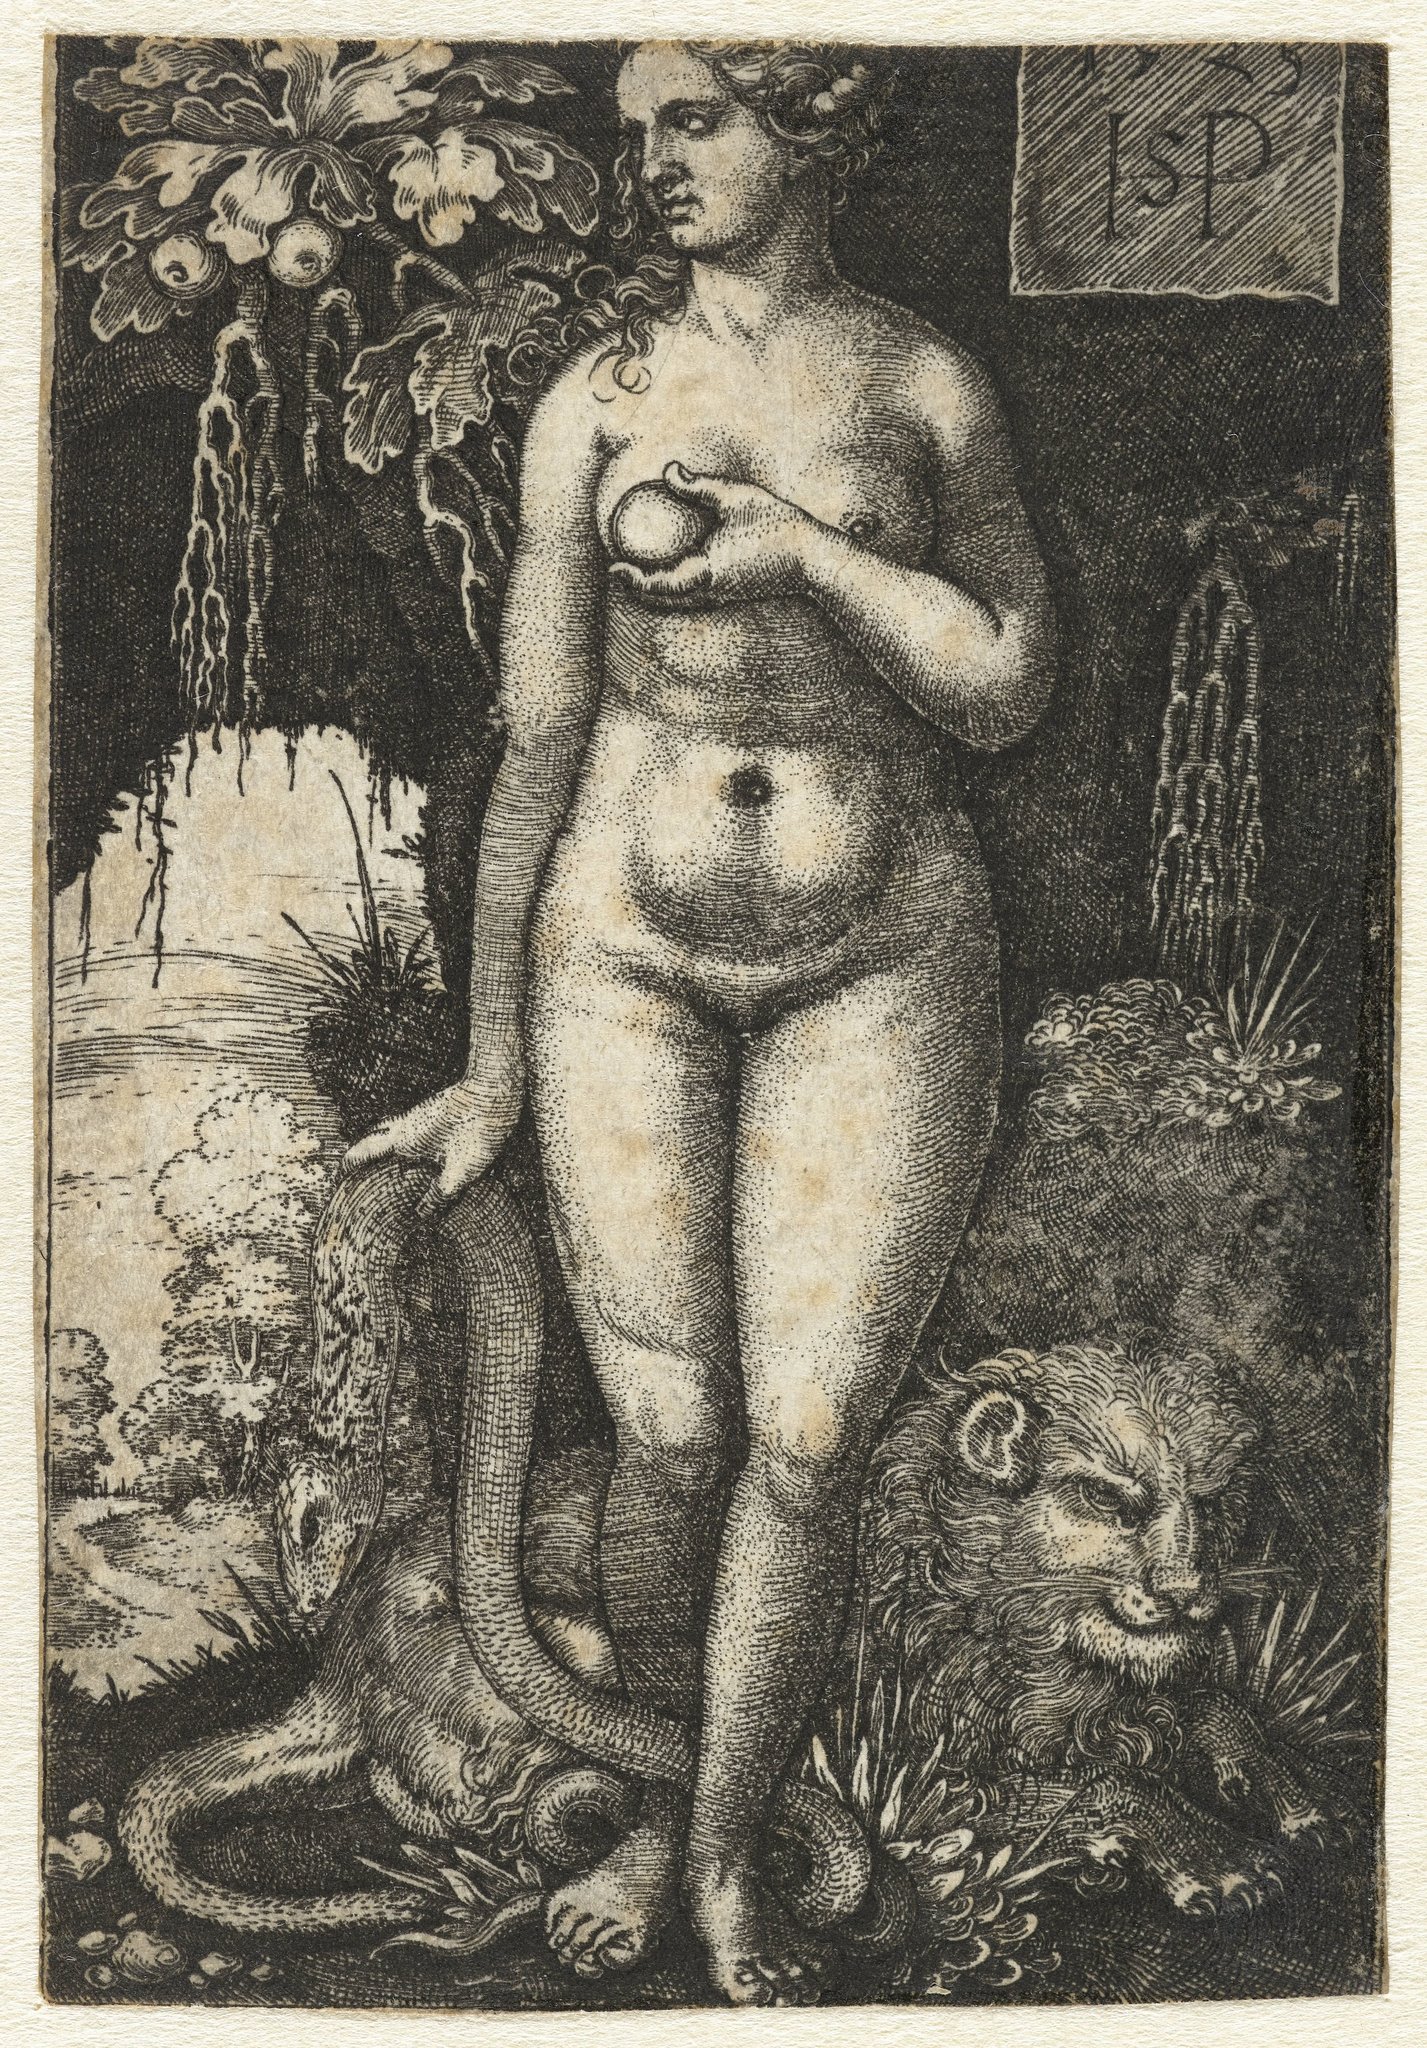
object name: print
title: Eva met slang en appel en liggende leeuw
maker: hans sebald beham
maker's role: designer, draughtsman, print maker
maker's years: 1500-1550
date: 1523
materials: paper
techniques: engraving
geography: nuremberg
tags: eve (not in biblical context), beasts of prey, predatory animals: lion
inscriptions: collector's mark: Lugt 240